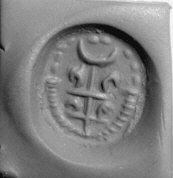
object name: stamp seal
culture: sasanian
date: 201-700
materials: mineral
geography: iran or mesopotamia